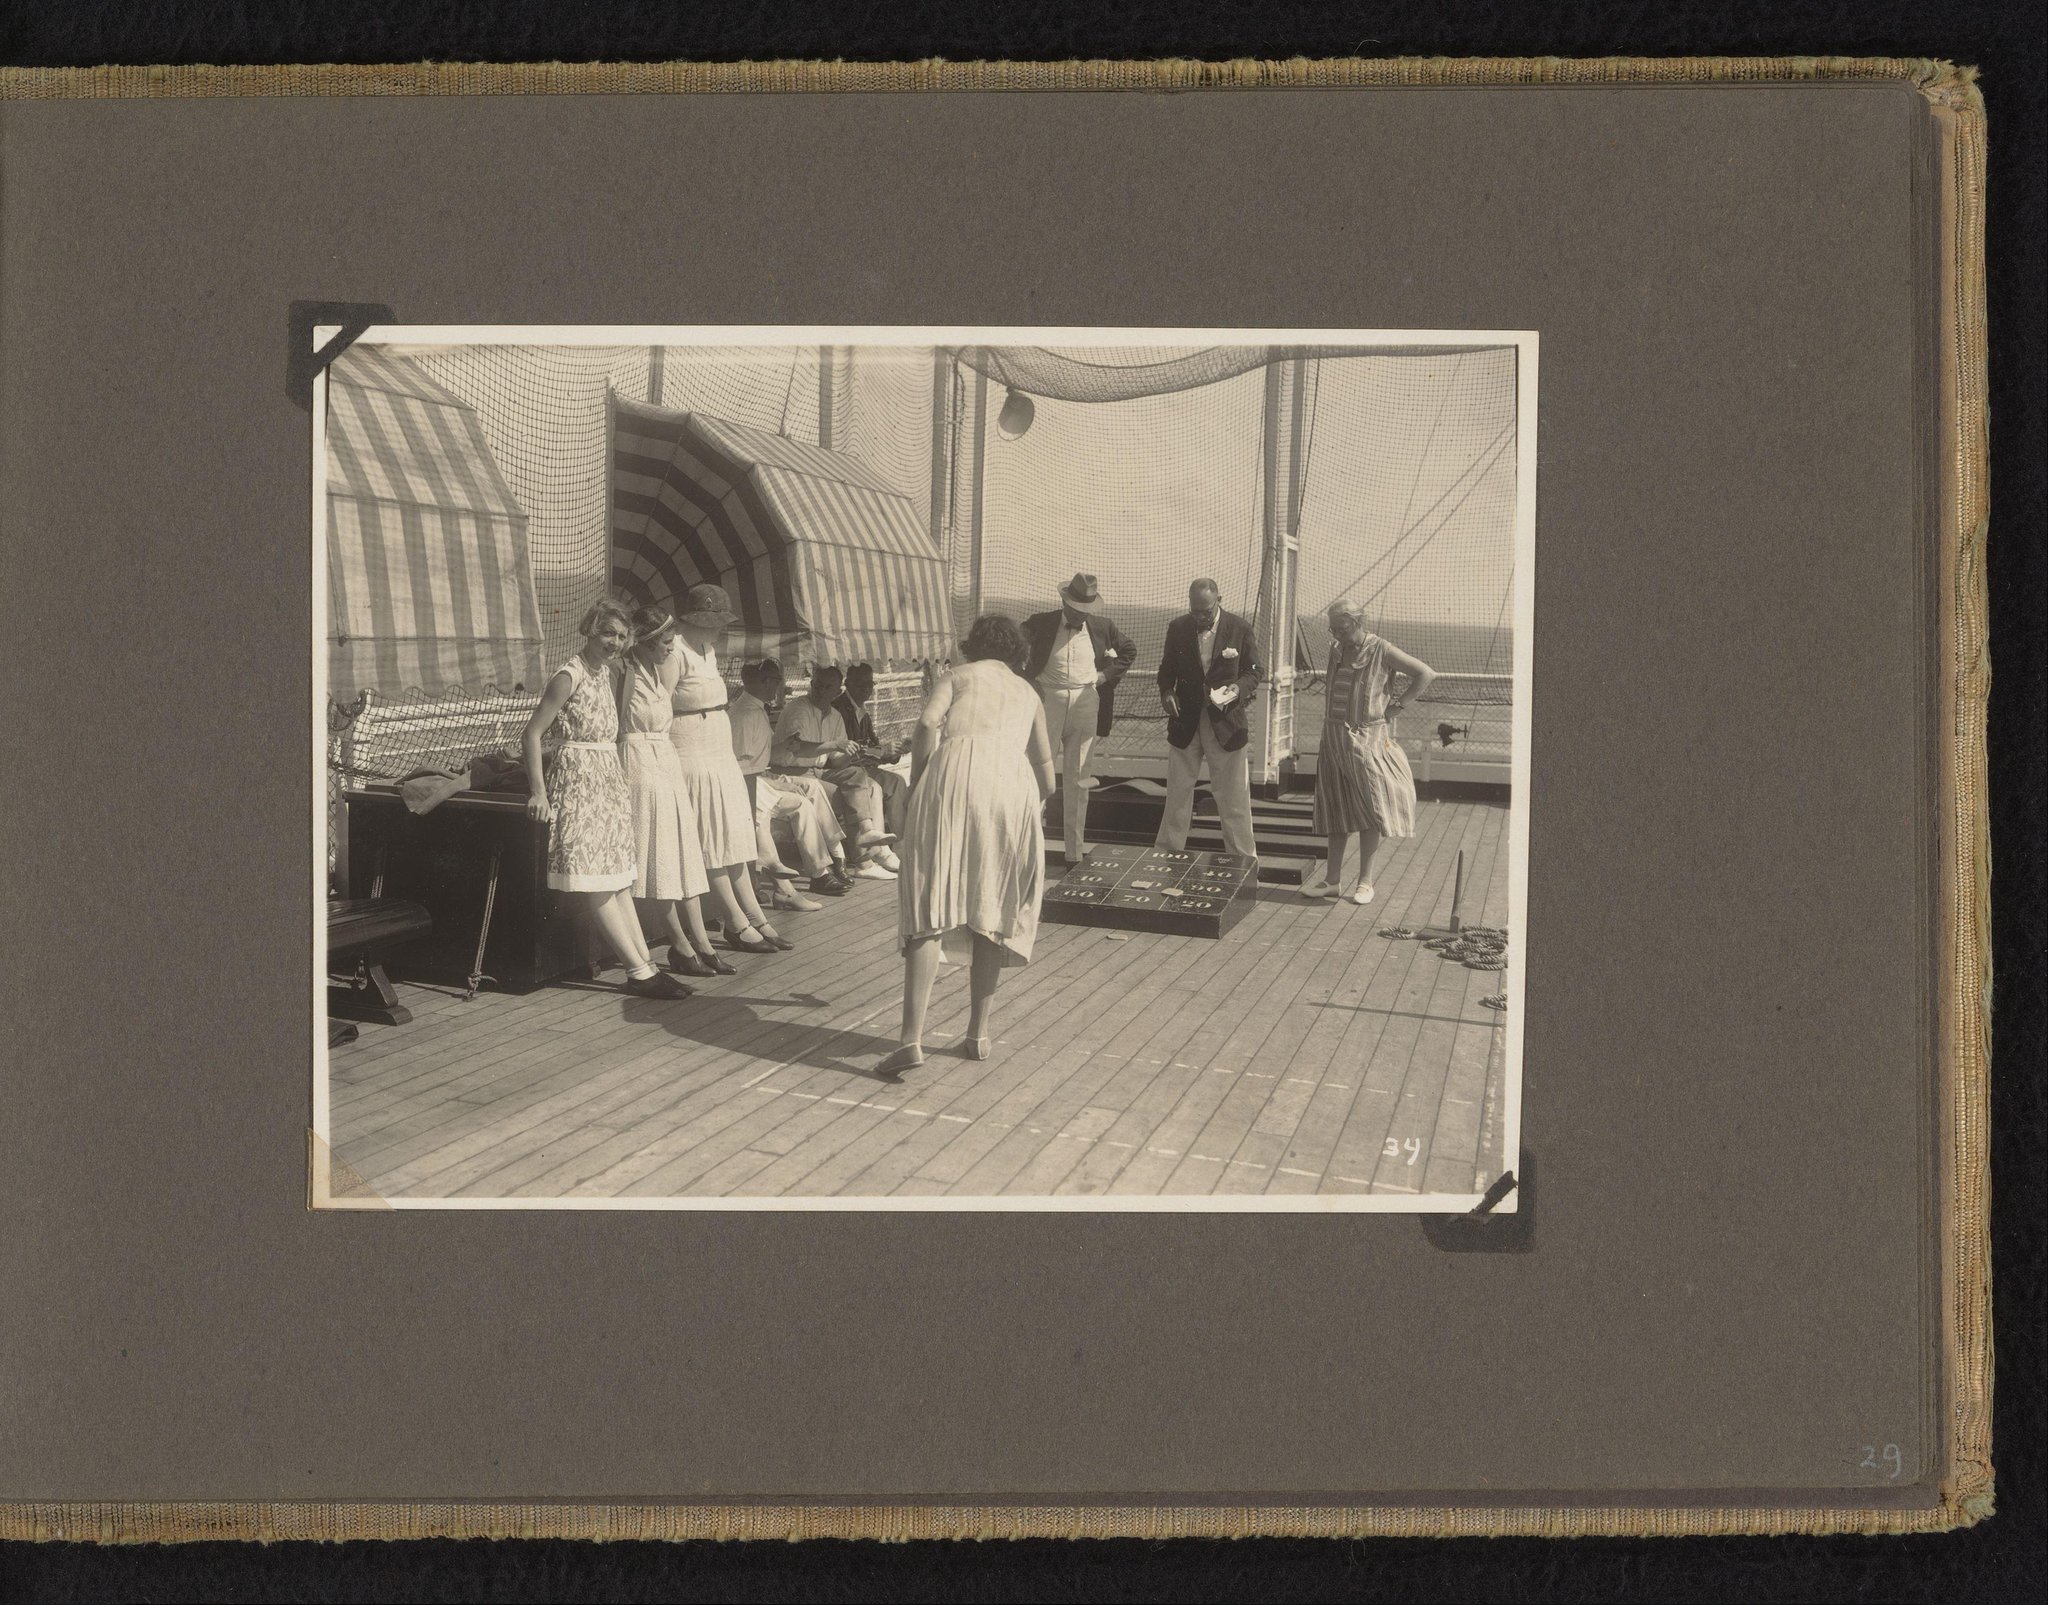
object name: album leaf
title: Aan dek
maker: Anonymous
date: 1930-1931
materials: cardboard, photographic support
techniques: gelatin silver print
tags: passenger liner, passengers ~ ship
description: Albumblad met een foto van een groep mensen dat aan dek van een schip een spelletje speelt. Onderdeel van fotoalbum 'Studentenalbum Indologen'.